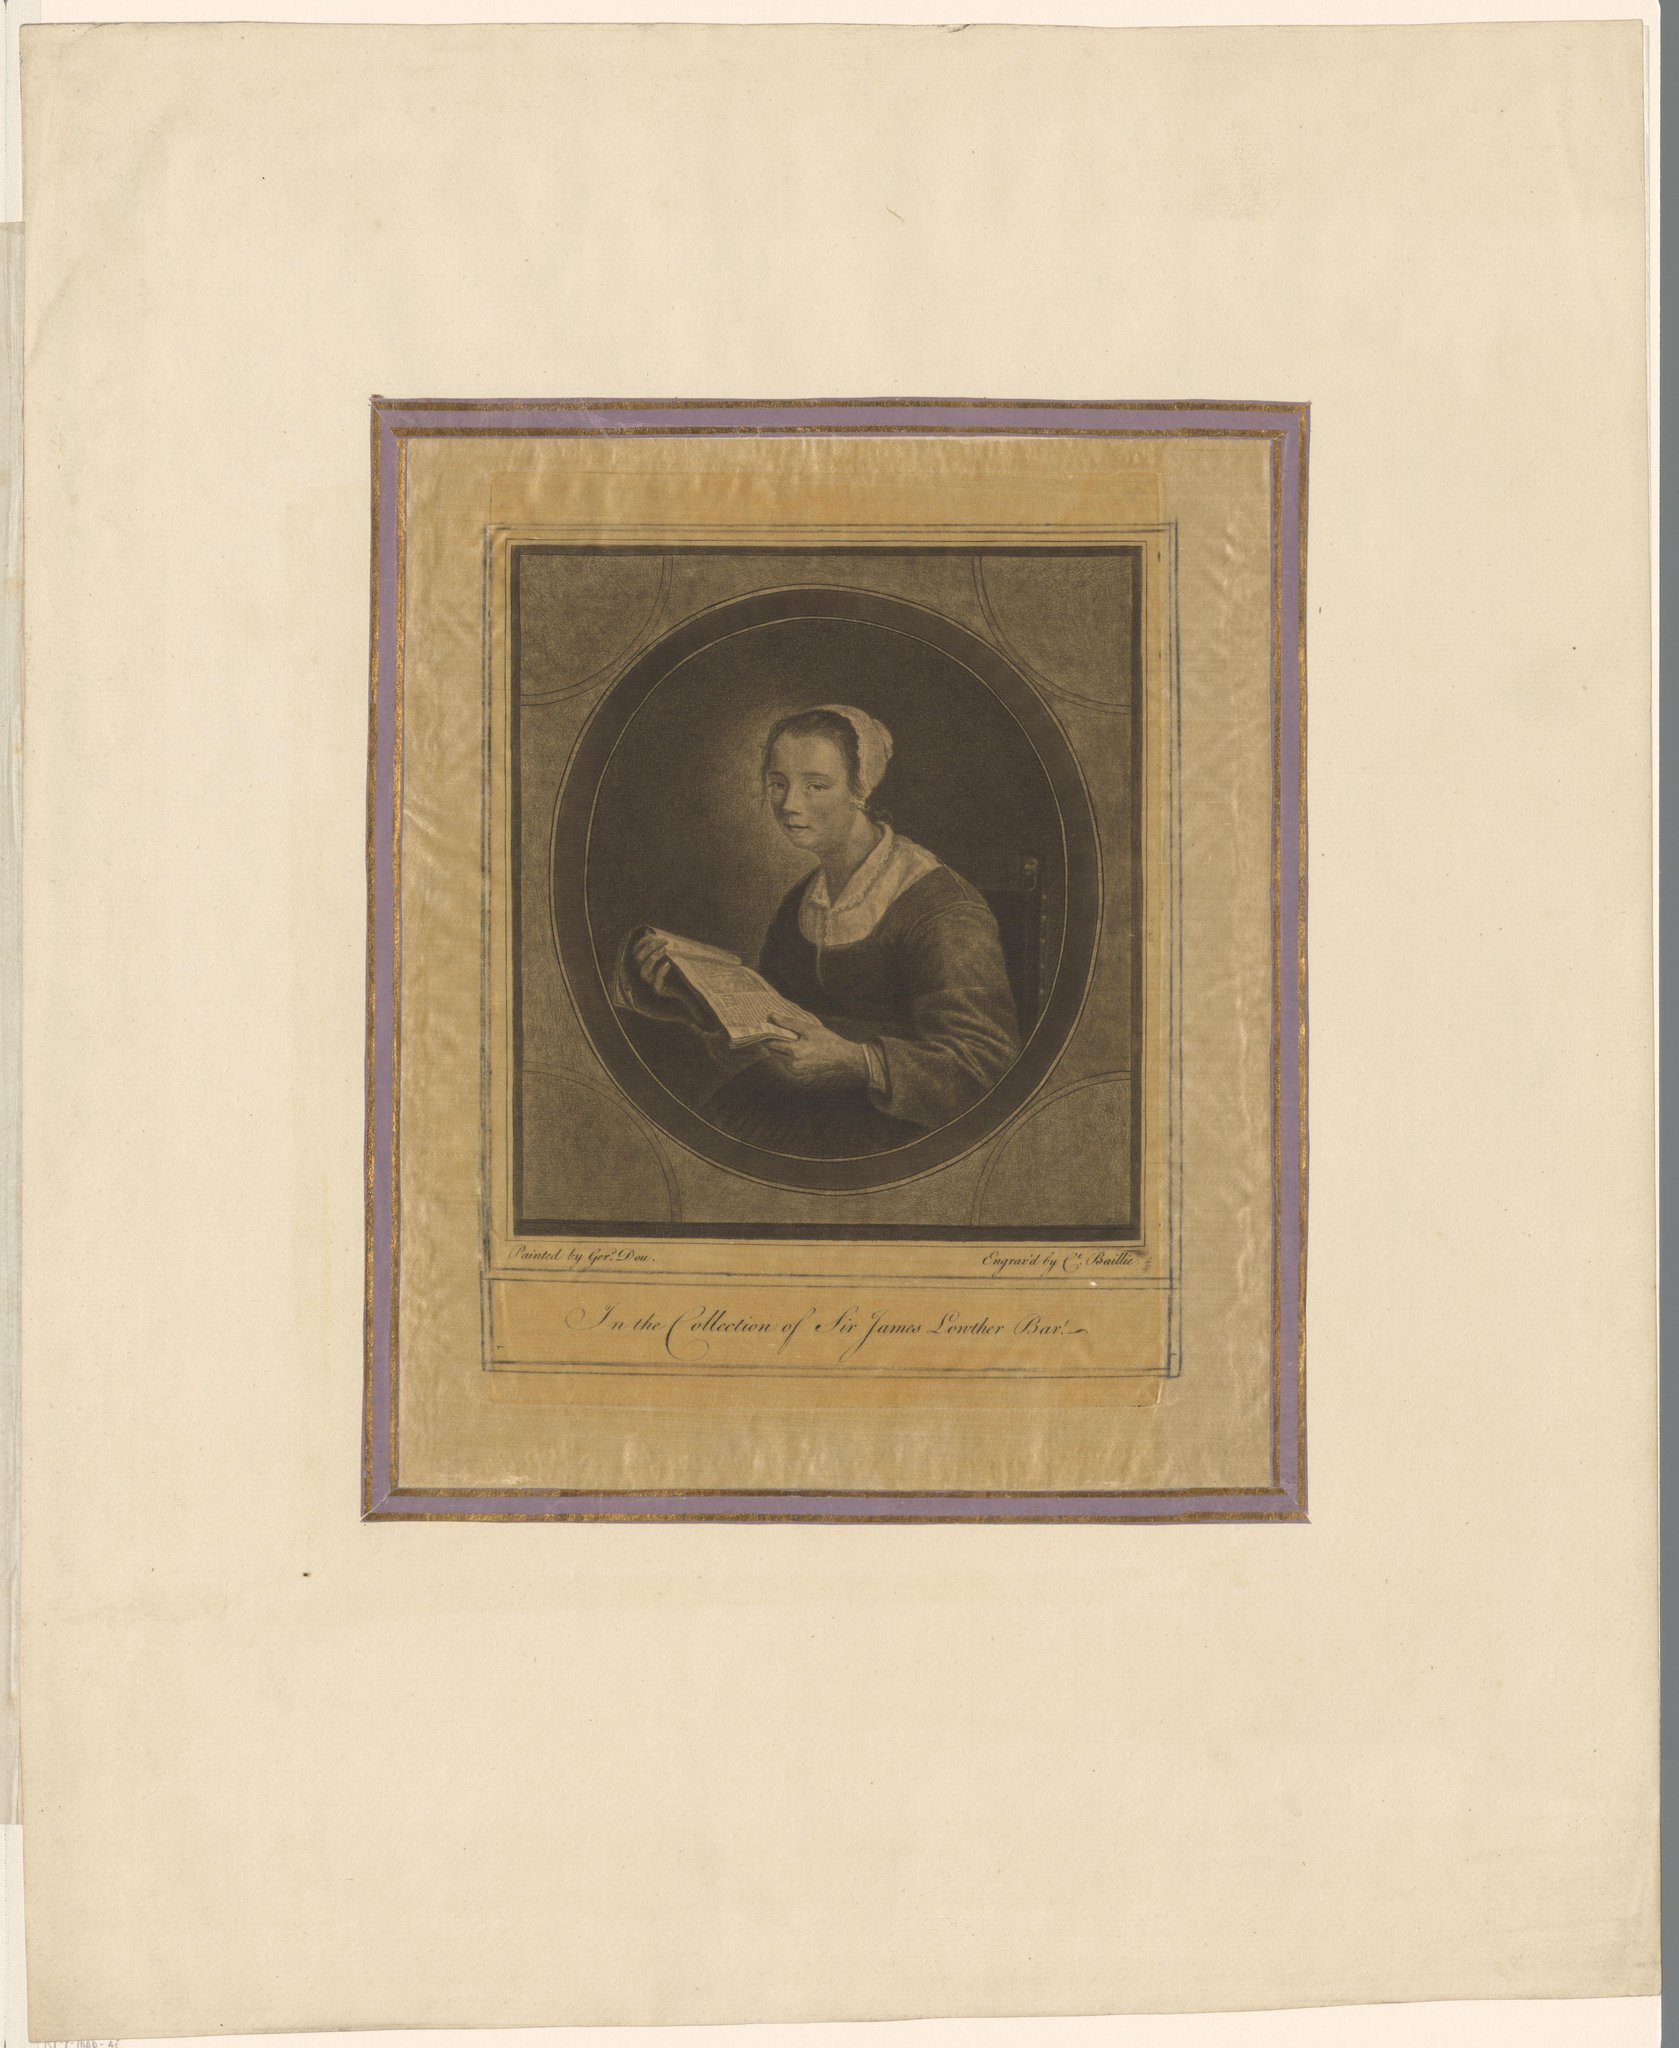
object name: print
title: Zittende vrouw met boek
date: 1760-1779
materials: paper, silk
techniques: drypoint, etching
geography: england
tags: sitting figure - aa - female human figure, book - mm - book open